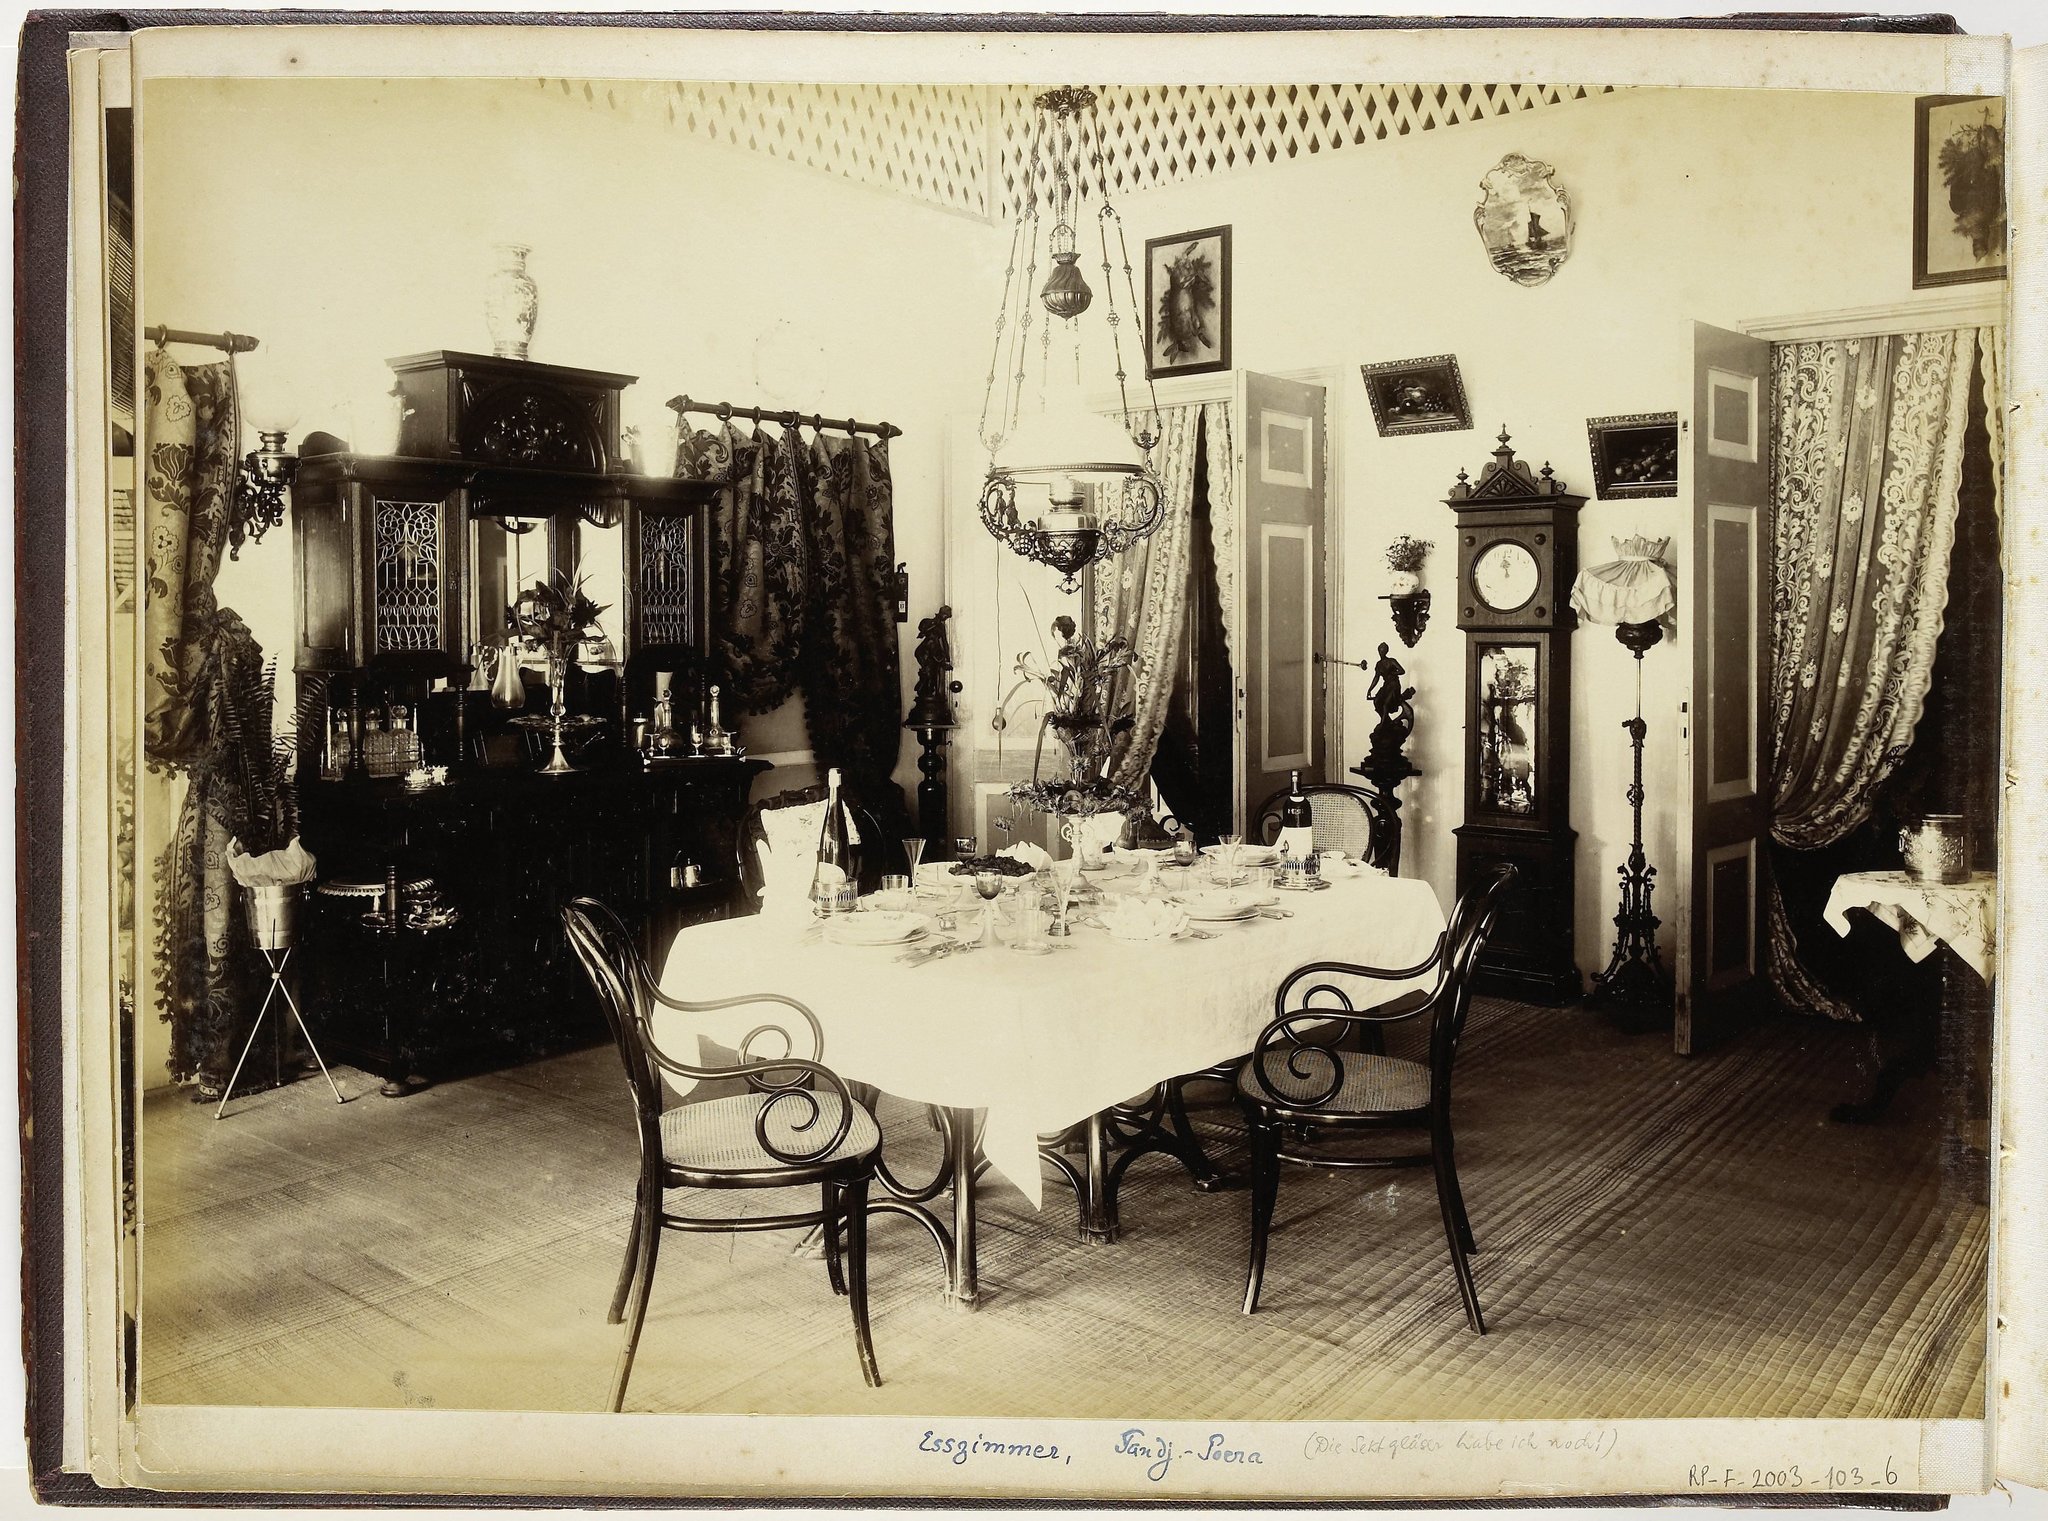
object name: photograph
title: Eetkamer van het huis van Paul Sandel in Tandjong Poera, Langkat Sumatra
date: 1900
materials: cardboard, paper, photographic support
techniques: albumen print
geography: bindjai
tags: table, laid table: table-ware, table-decoration, etc.